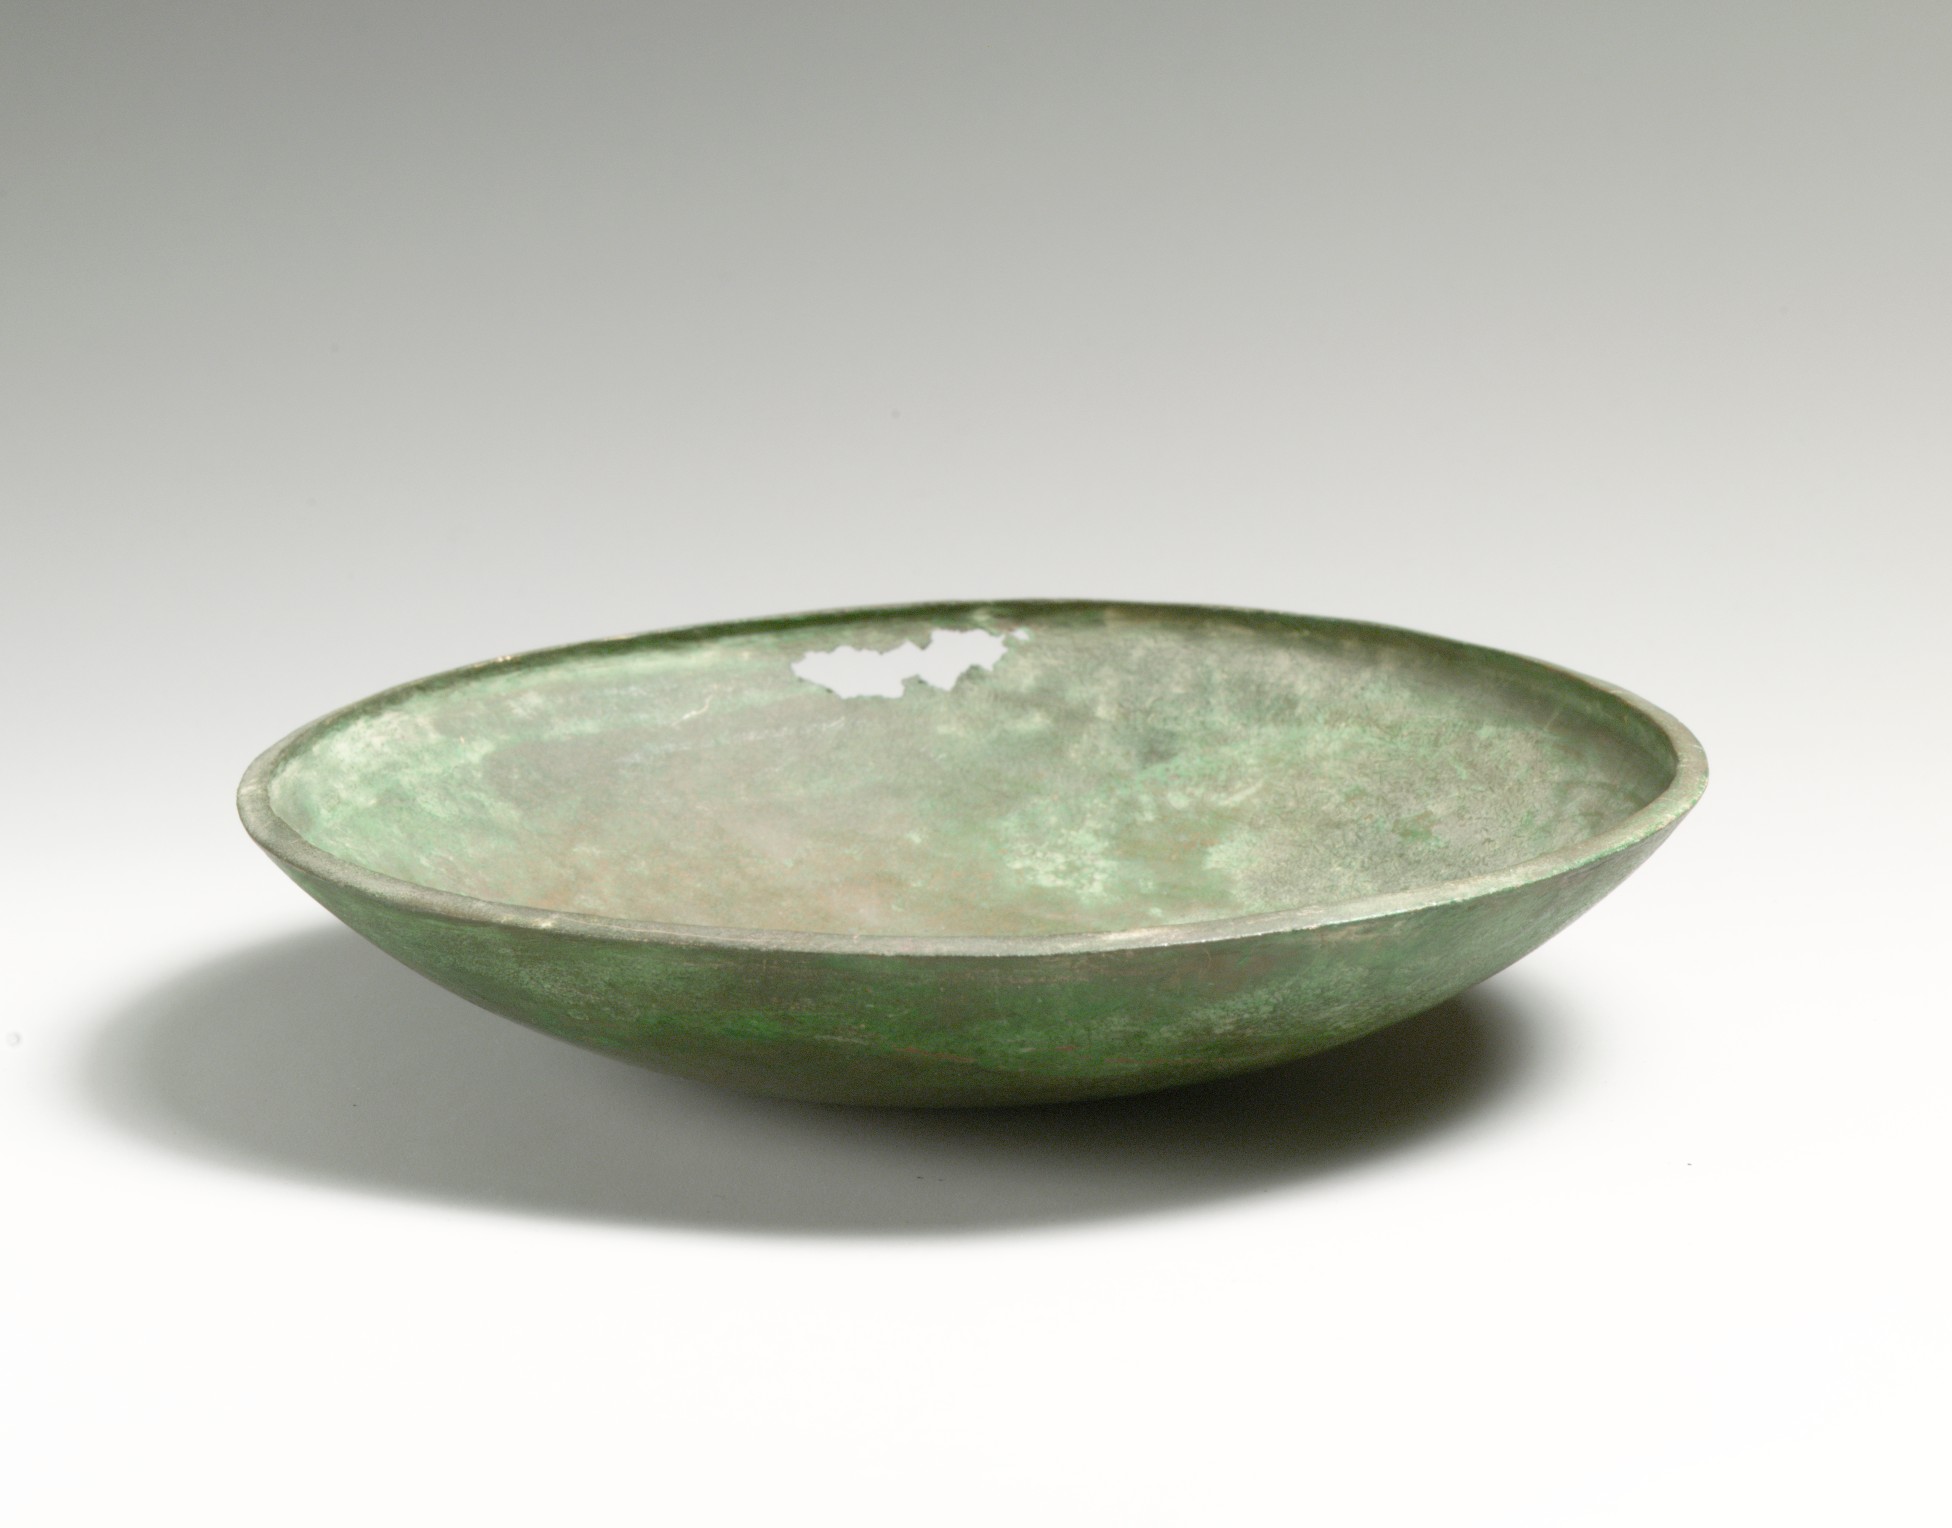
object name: bowl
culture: cypriot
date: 3900 BCE-100 CE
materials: bronze